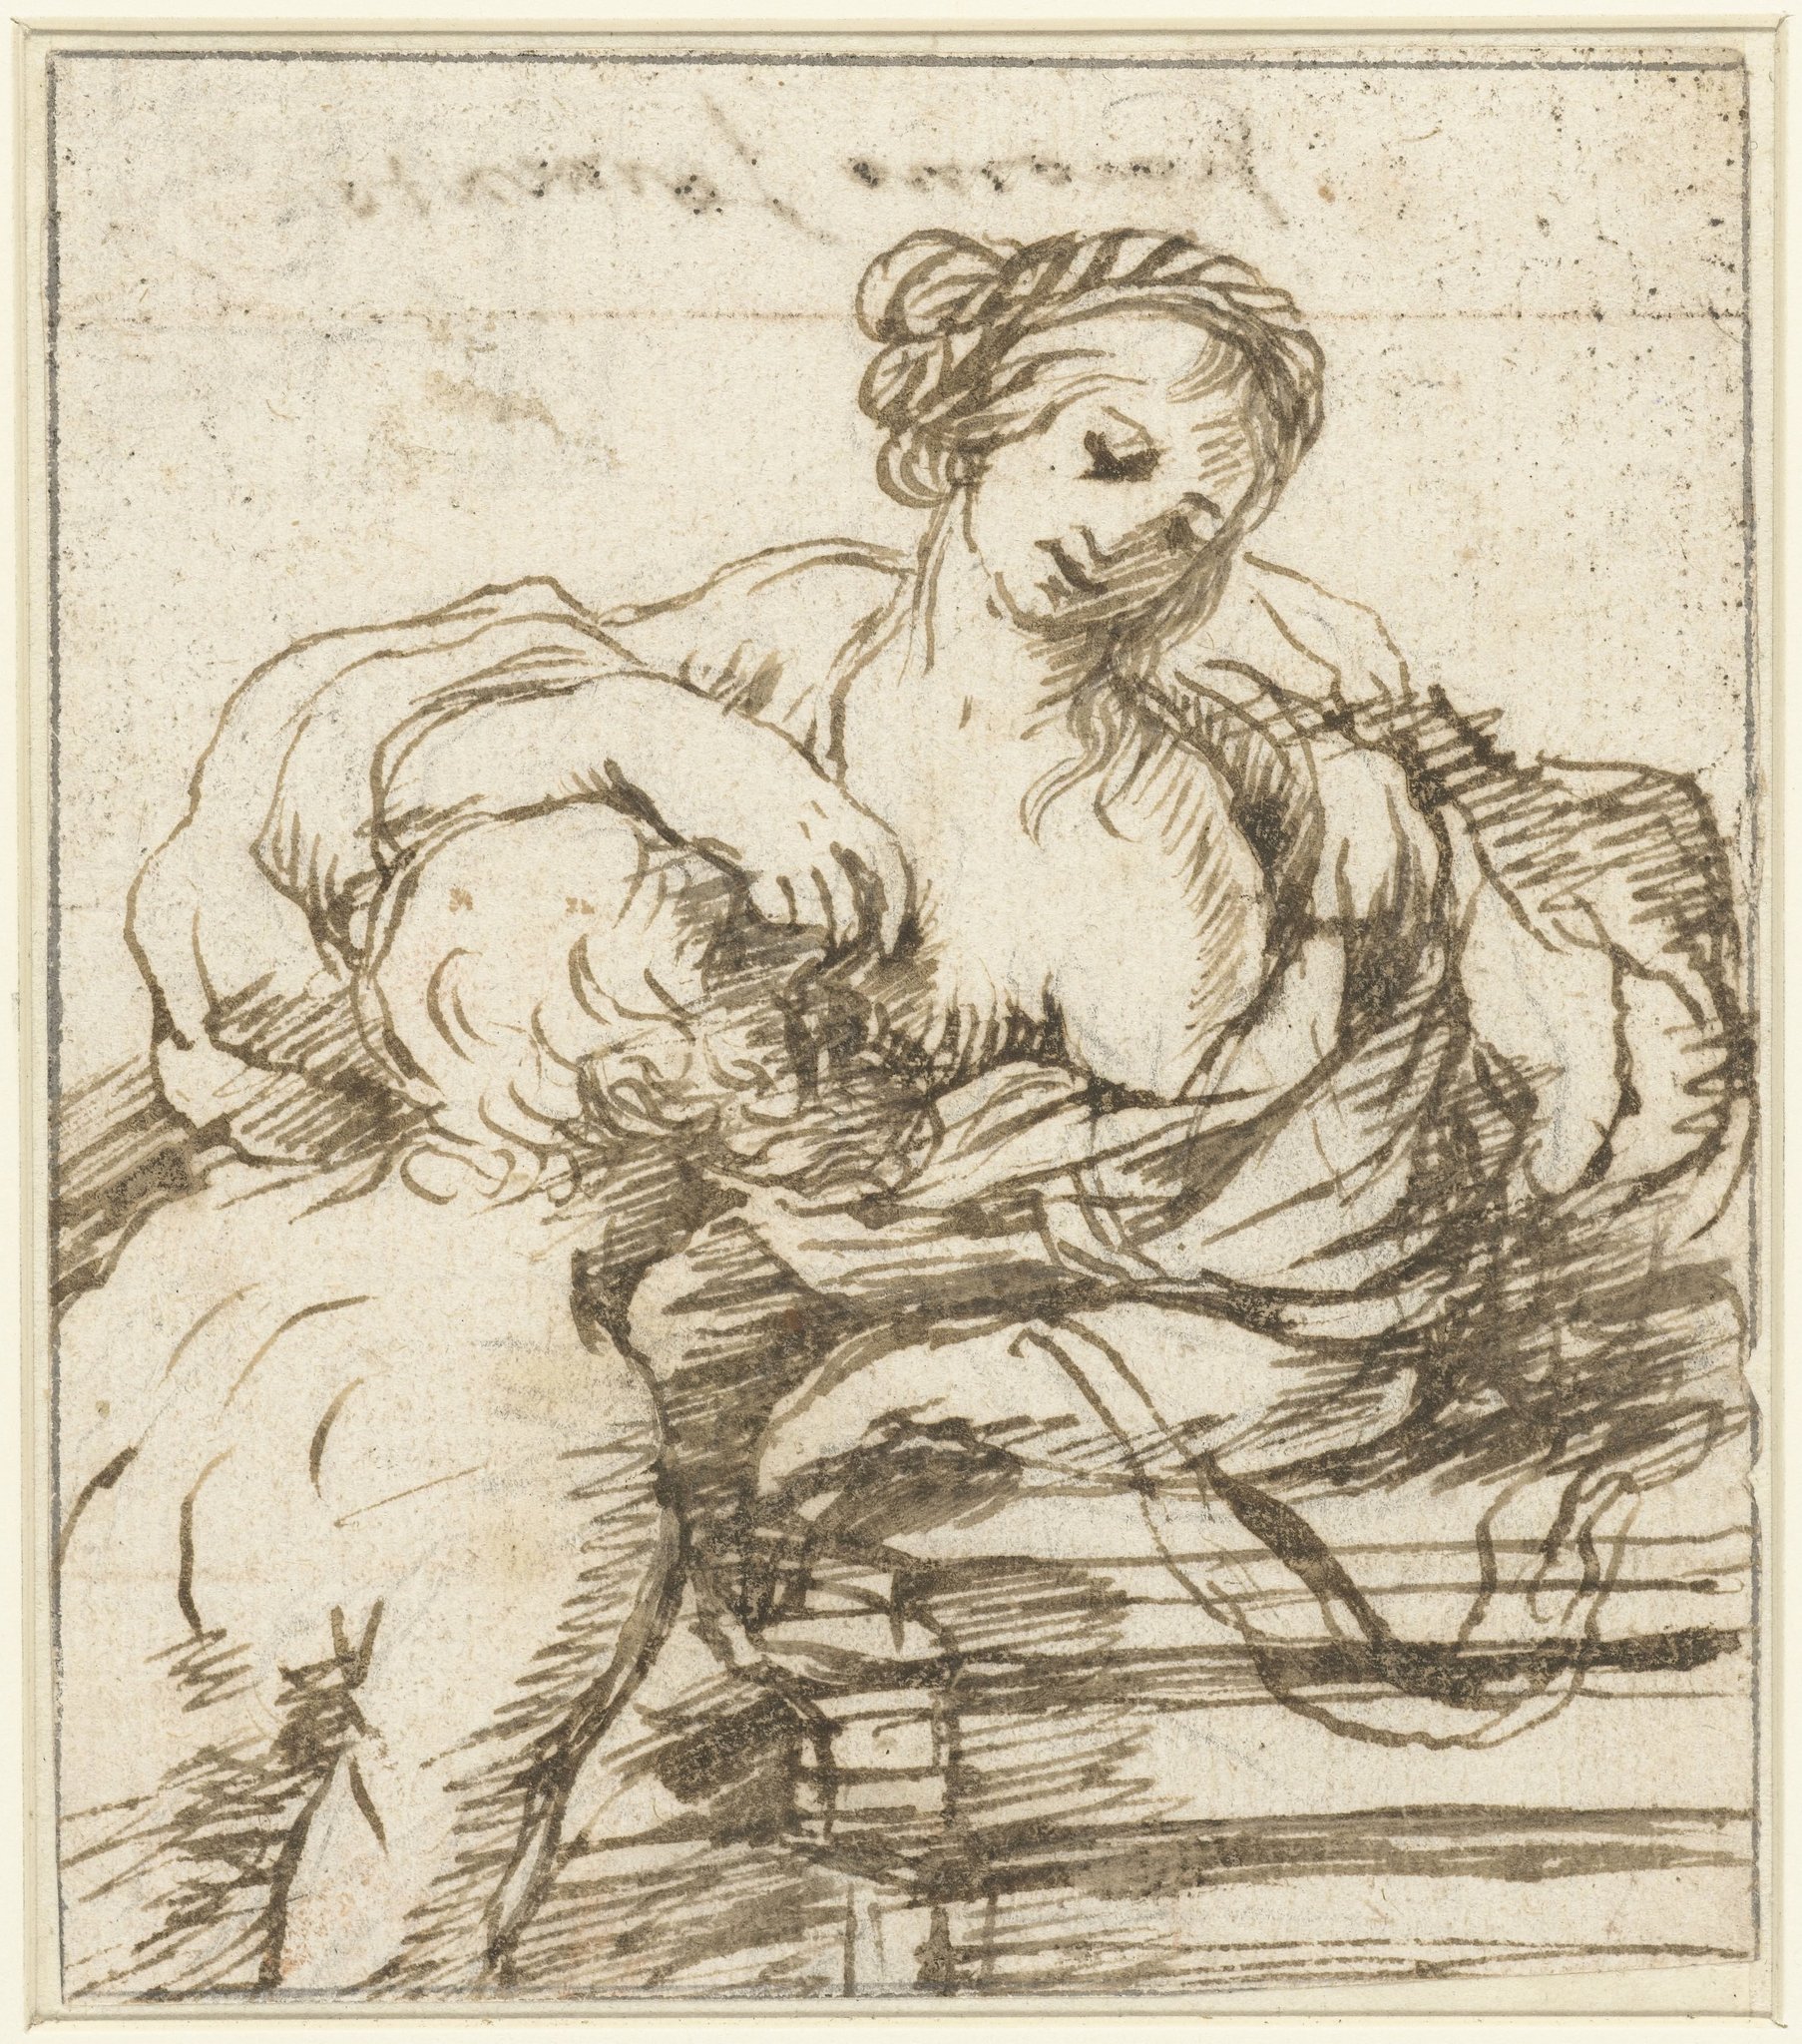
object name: drawing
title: Cimon en Pero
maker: giacomo sementi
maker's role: draughtsman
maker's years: 1580-1636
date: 1590-1636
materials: ink, paper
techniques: pen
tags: pero suckling cimon ('caritas romana')